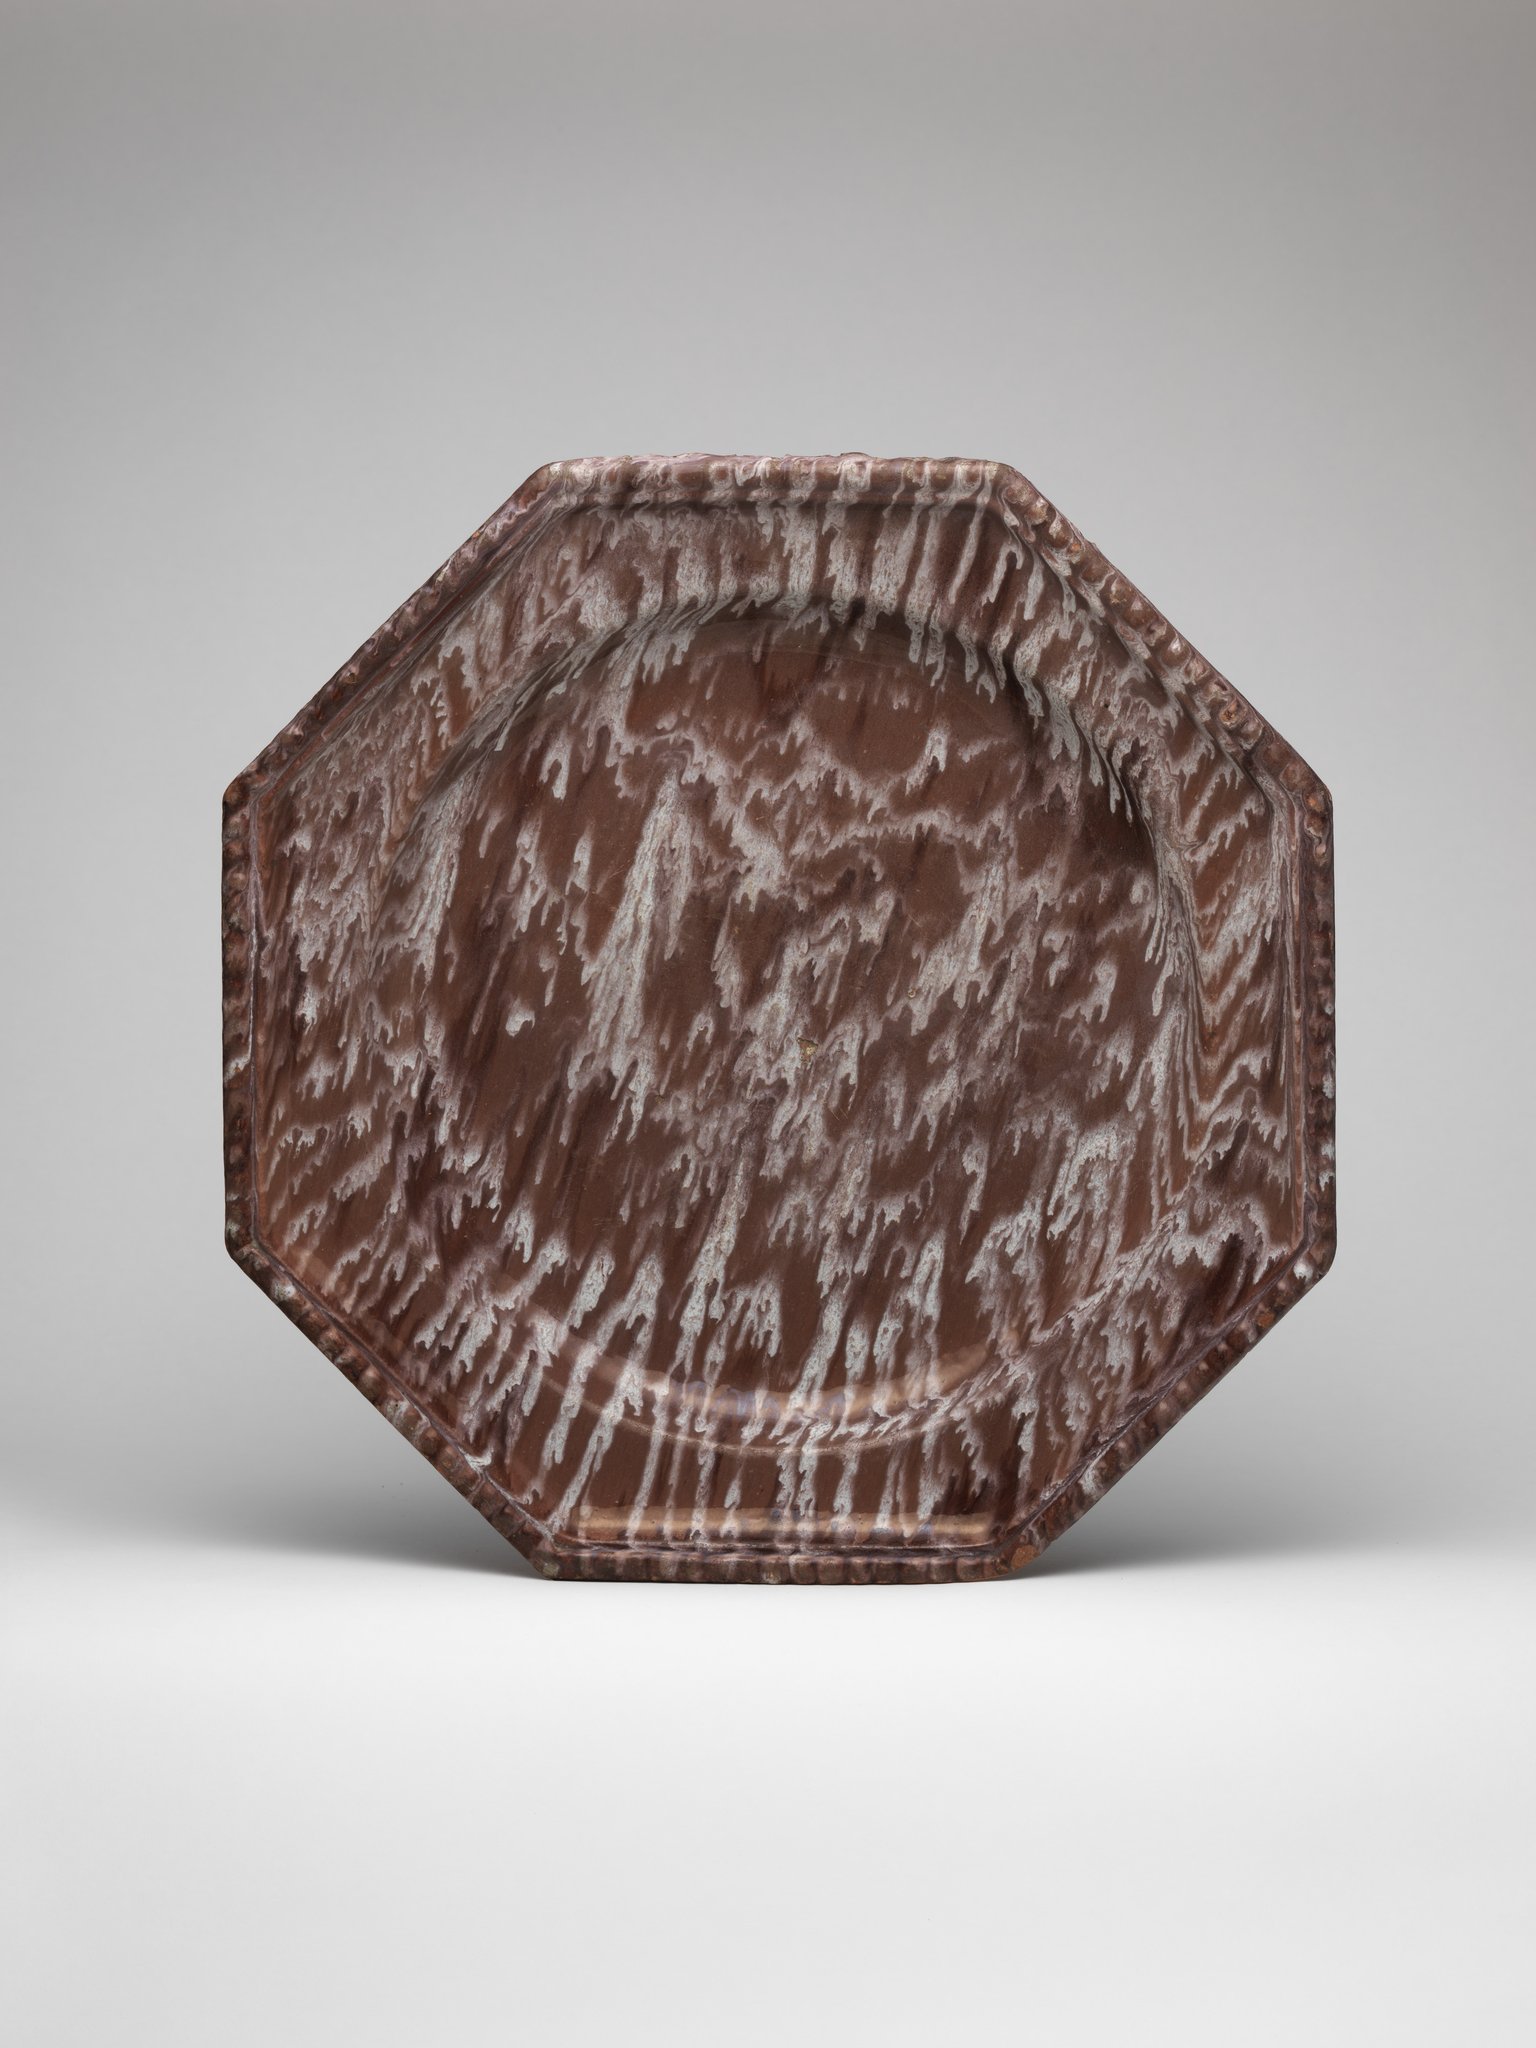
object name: plate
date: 1720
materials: faience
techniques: glazing